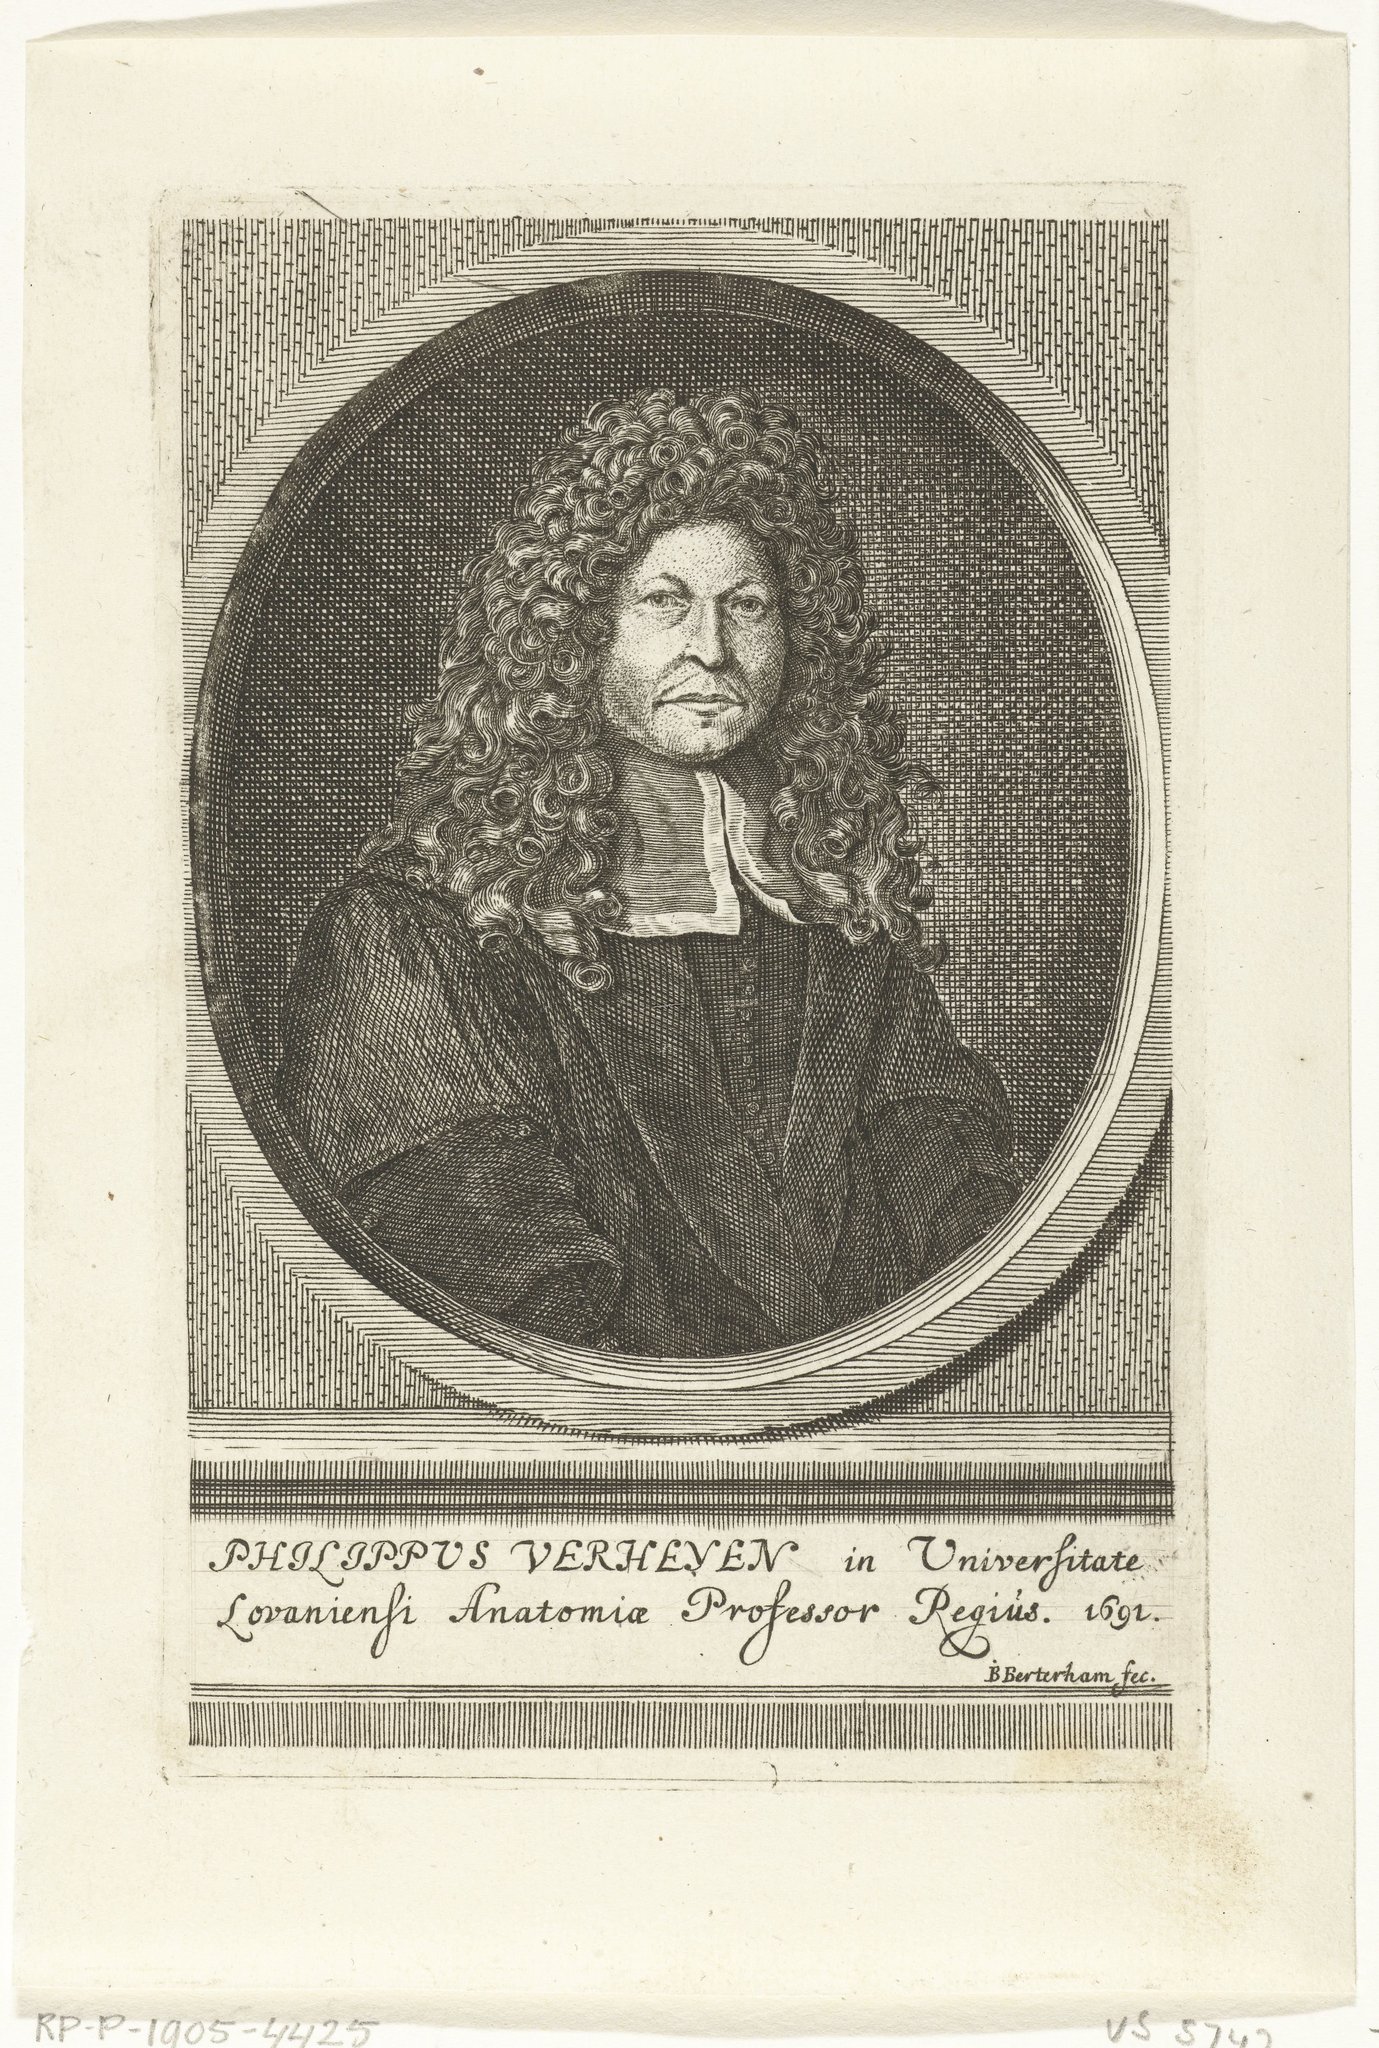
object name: print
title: Portret van chirurg Philip Verheyen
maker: jan baptist berterham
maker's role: print maker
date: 1692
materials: paper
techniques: engraving, etching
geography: brussels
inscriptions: collector's mark: Lugt 2228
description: Portret van chirurg Philip Verheyen bij zijn aanstelling op de universtiteit van Leuven in 1692 in ovale omlijsting.